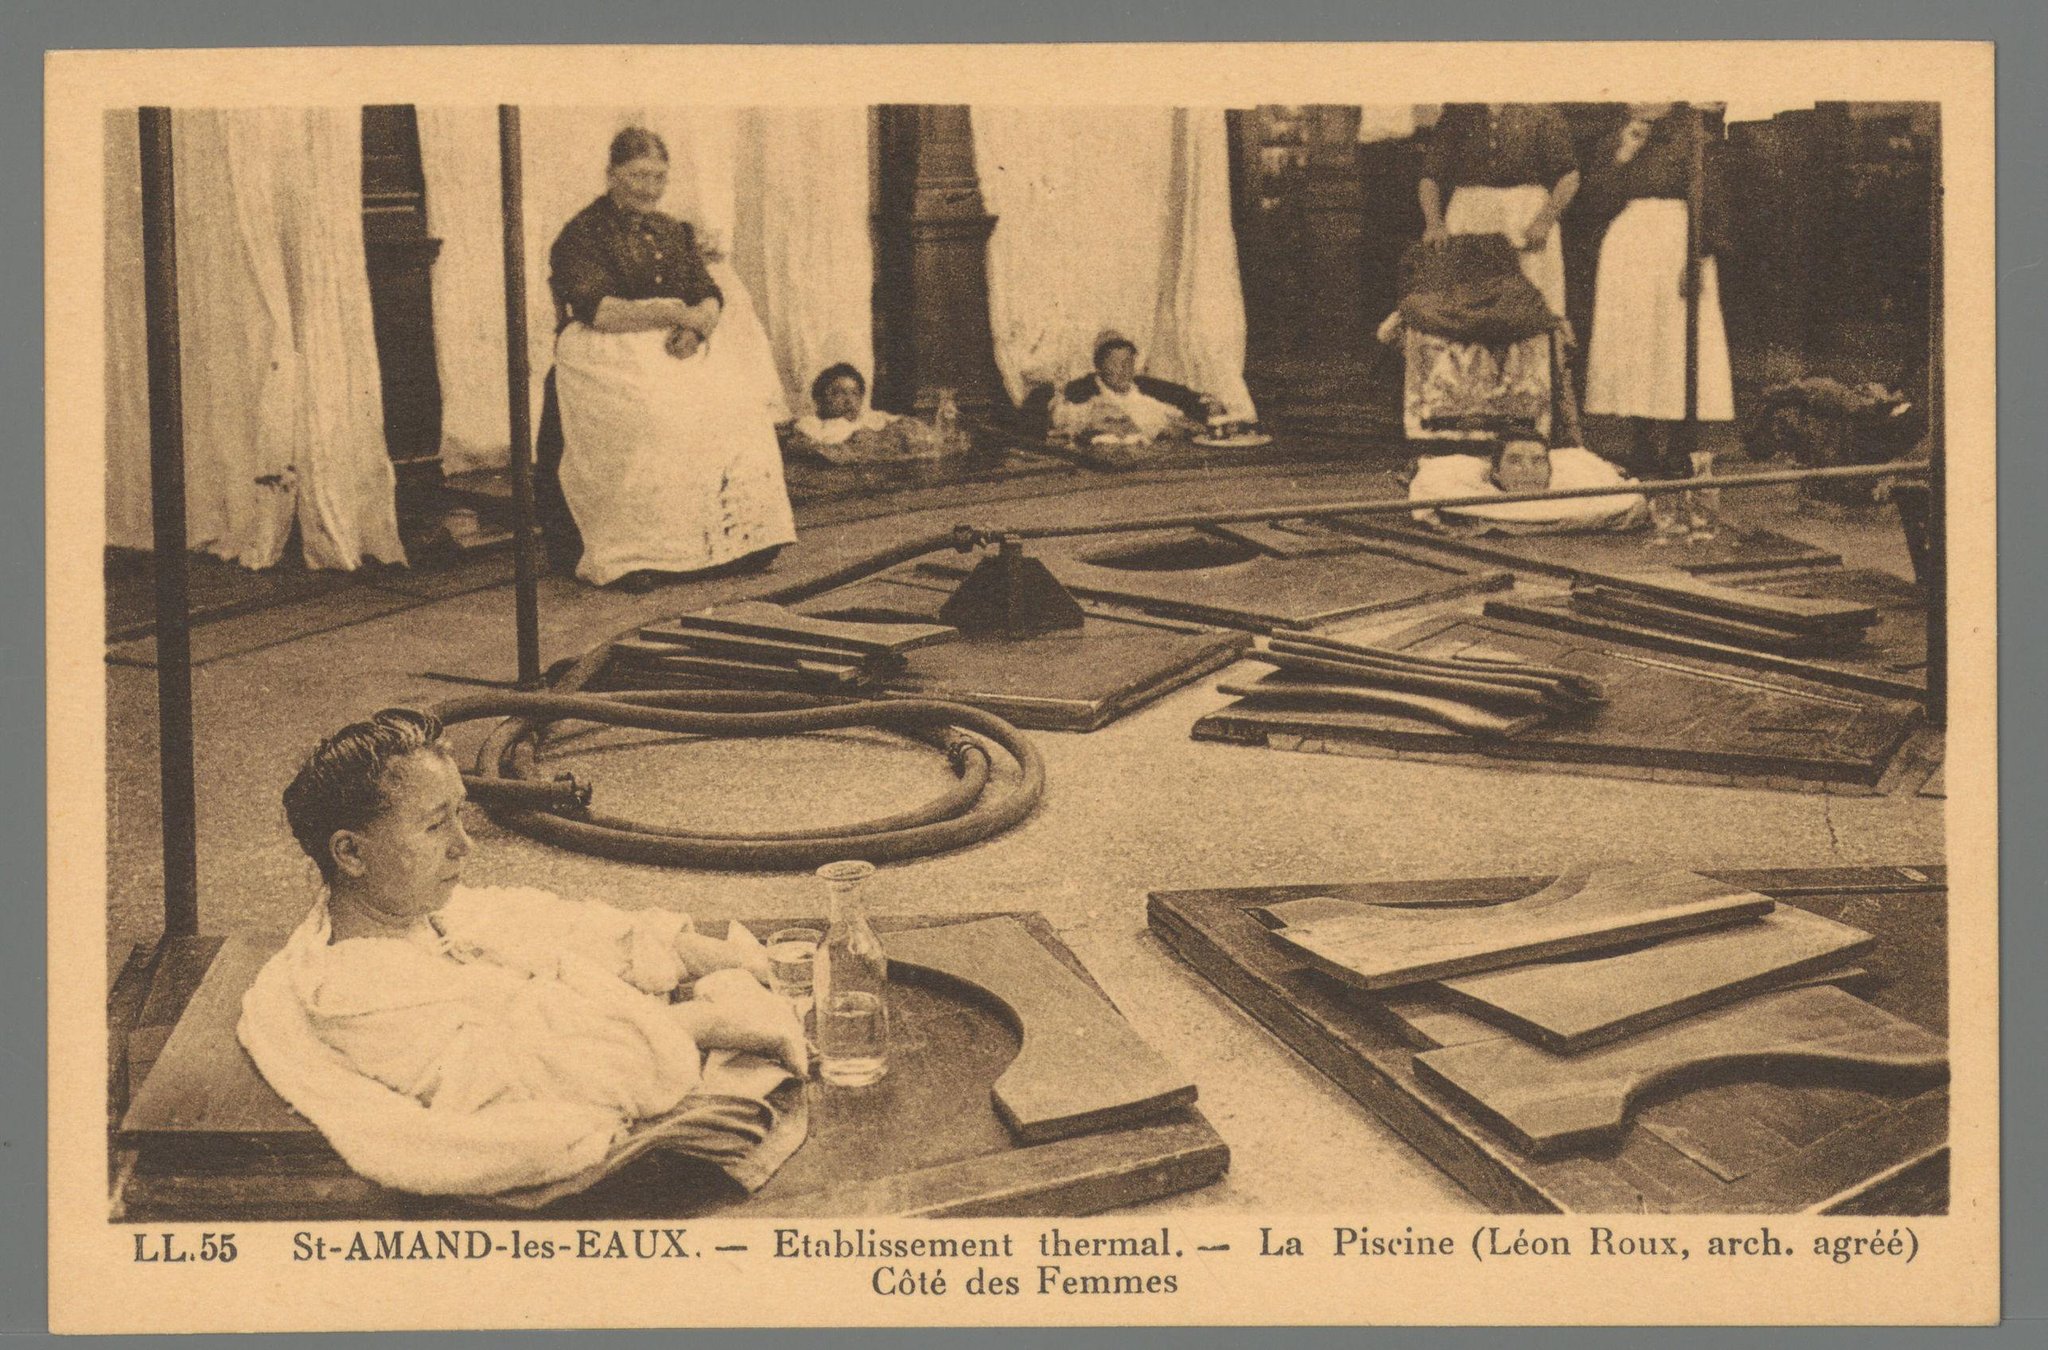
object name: photomechanical print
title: St.-Amand-les-Eaux. Etablissement thermal. La Piscine (Léon Roux, arch. agréé). Côté des Femmes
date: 1903-1920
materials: cardboard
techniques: photograph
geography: saint-amand-les-eaux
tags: adult woman (+ six persons), watering-place, spa